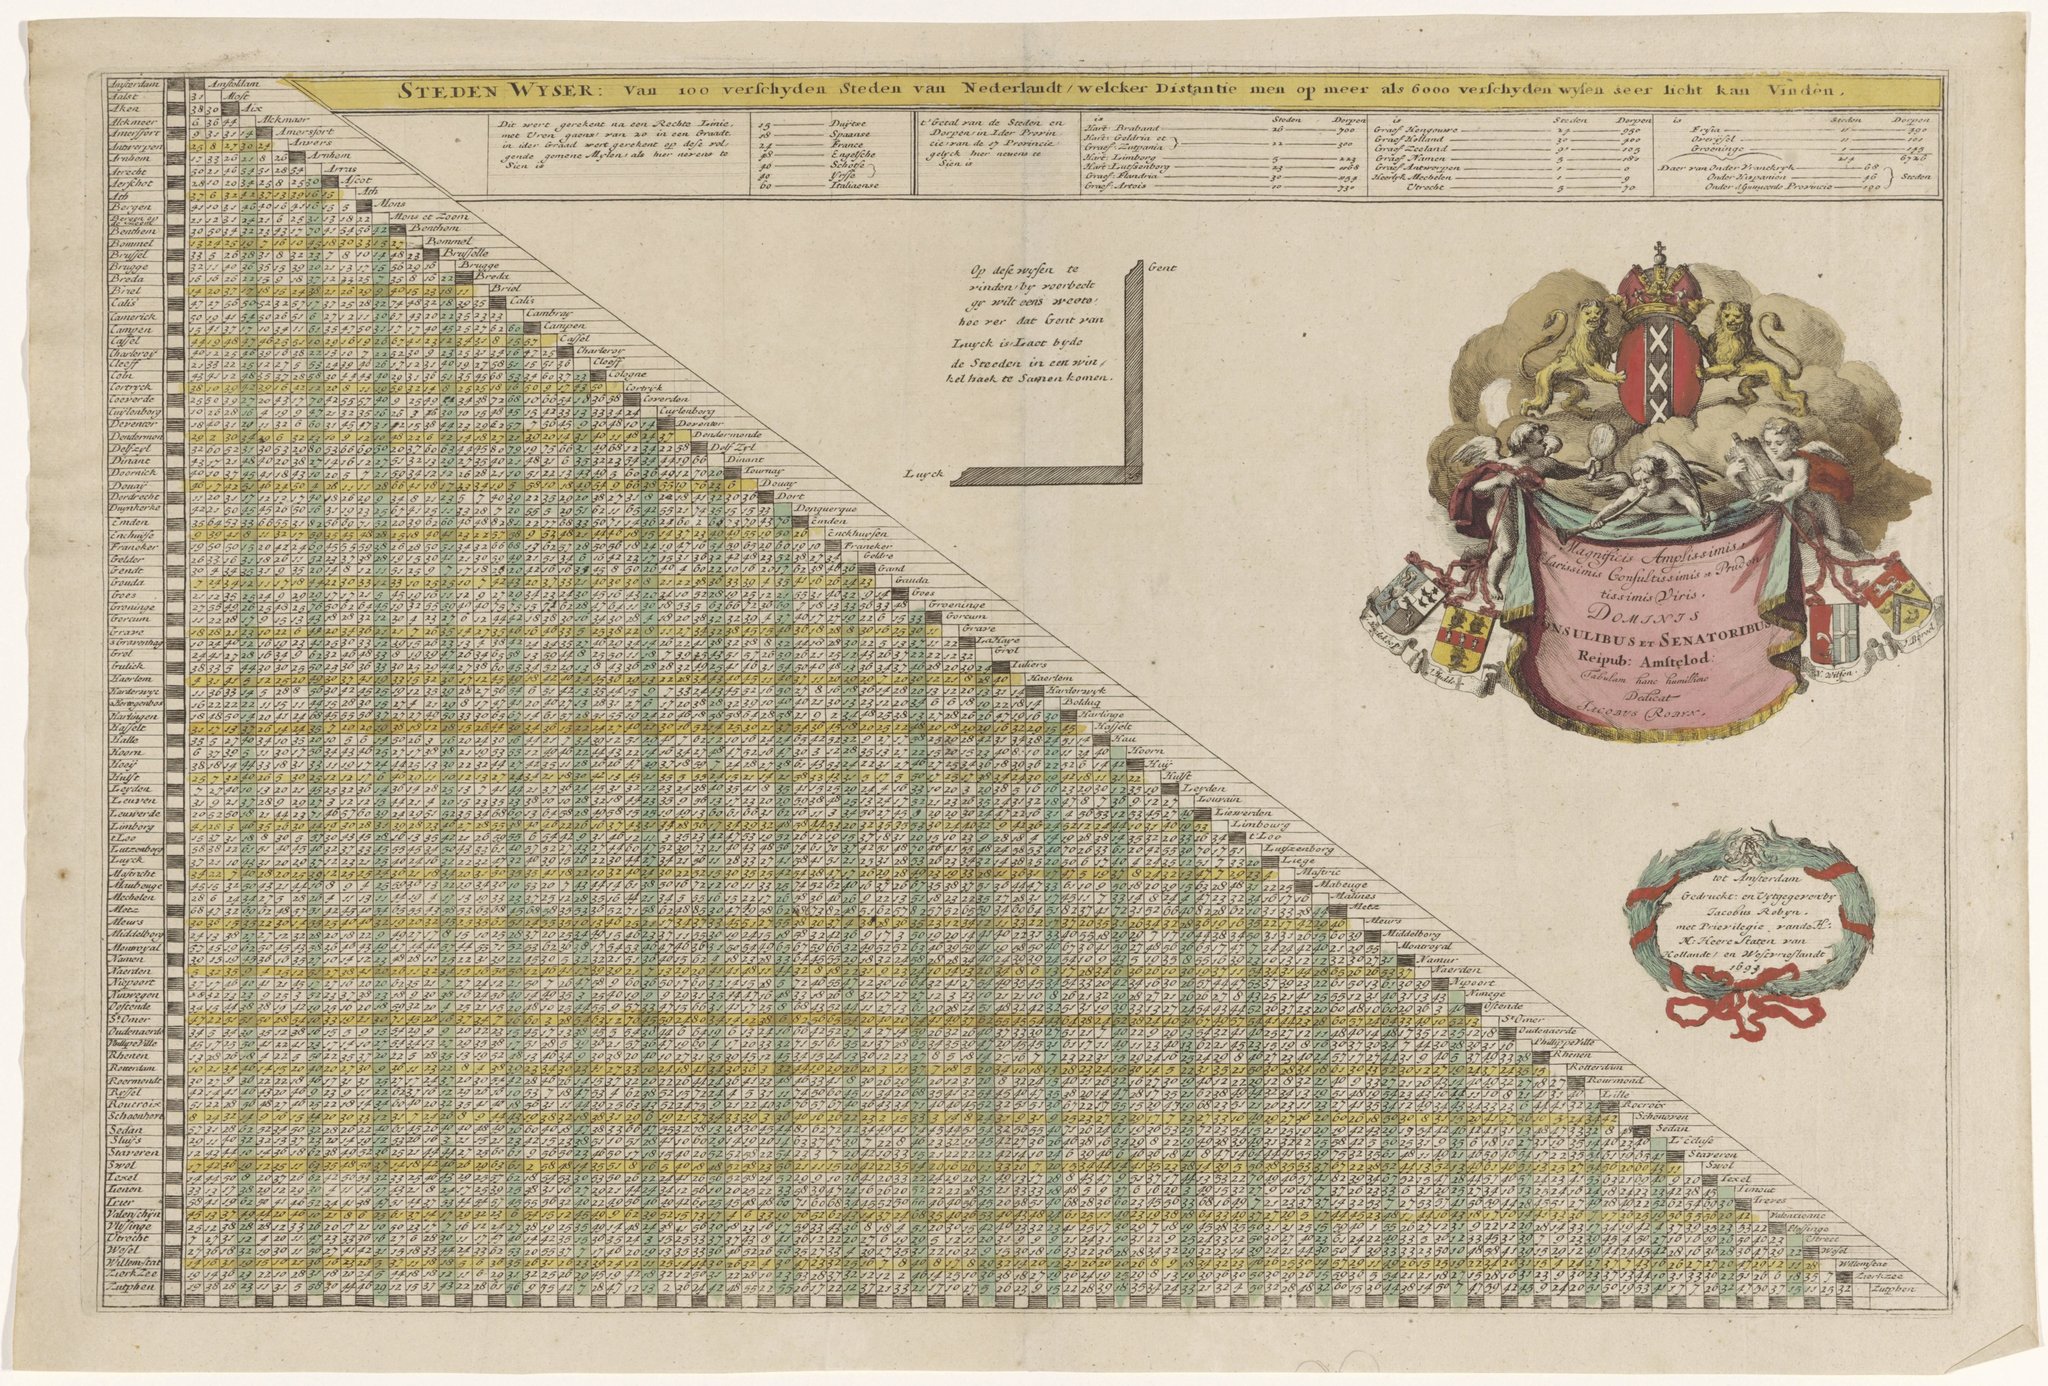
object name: print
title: Afstandstabel voor honderd Nederlandse steden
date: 1693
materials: paper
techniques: brush, engraving, etching, hand coloring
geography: amsterdam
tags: compass (+ variant), cupids: 'amores', 'amoretti', 'putti'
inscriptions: collector's mark: Lugt 2228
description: Afstandstabel waarin staat wat de onderlinge afstand is van honderd belangrijke steden in Nederland. Met rechts het wapenschild van Amsterdam, gekroond met de keizerskroon.